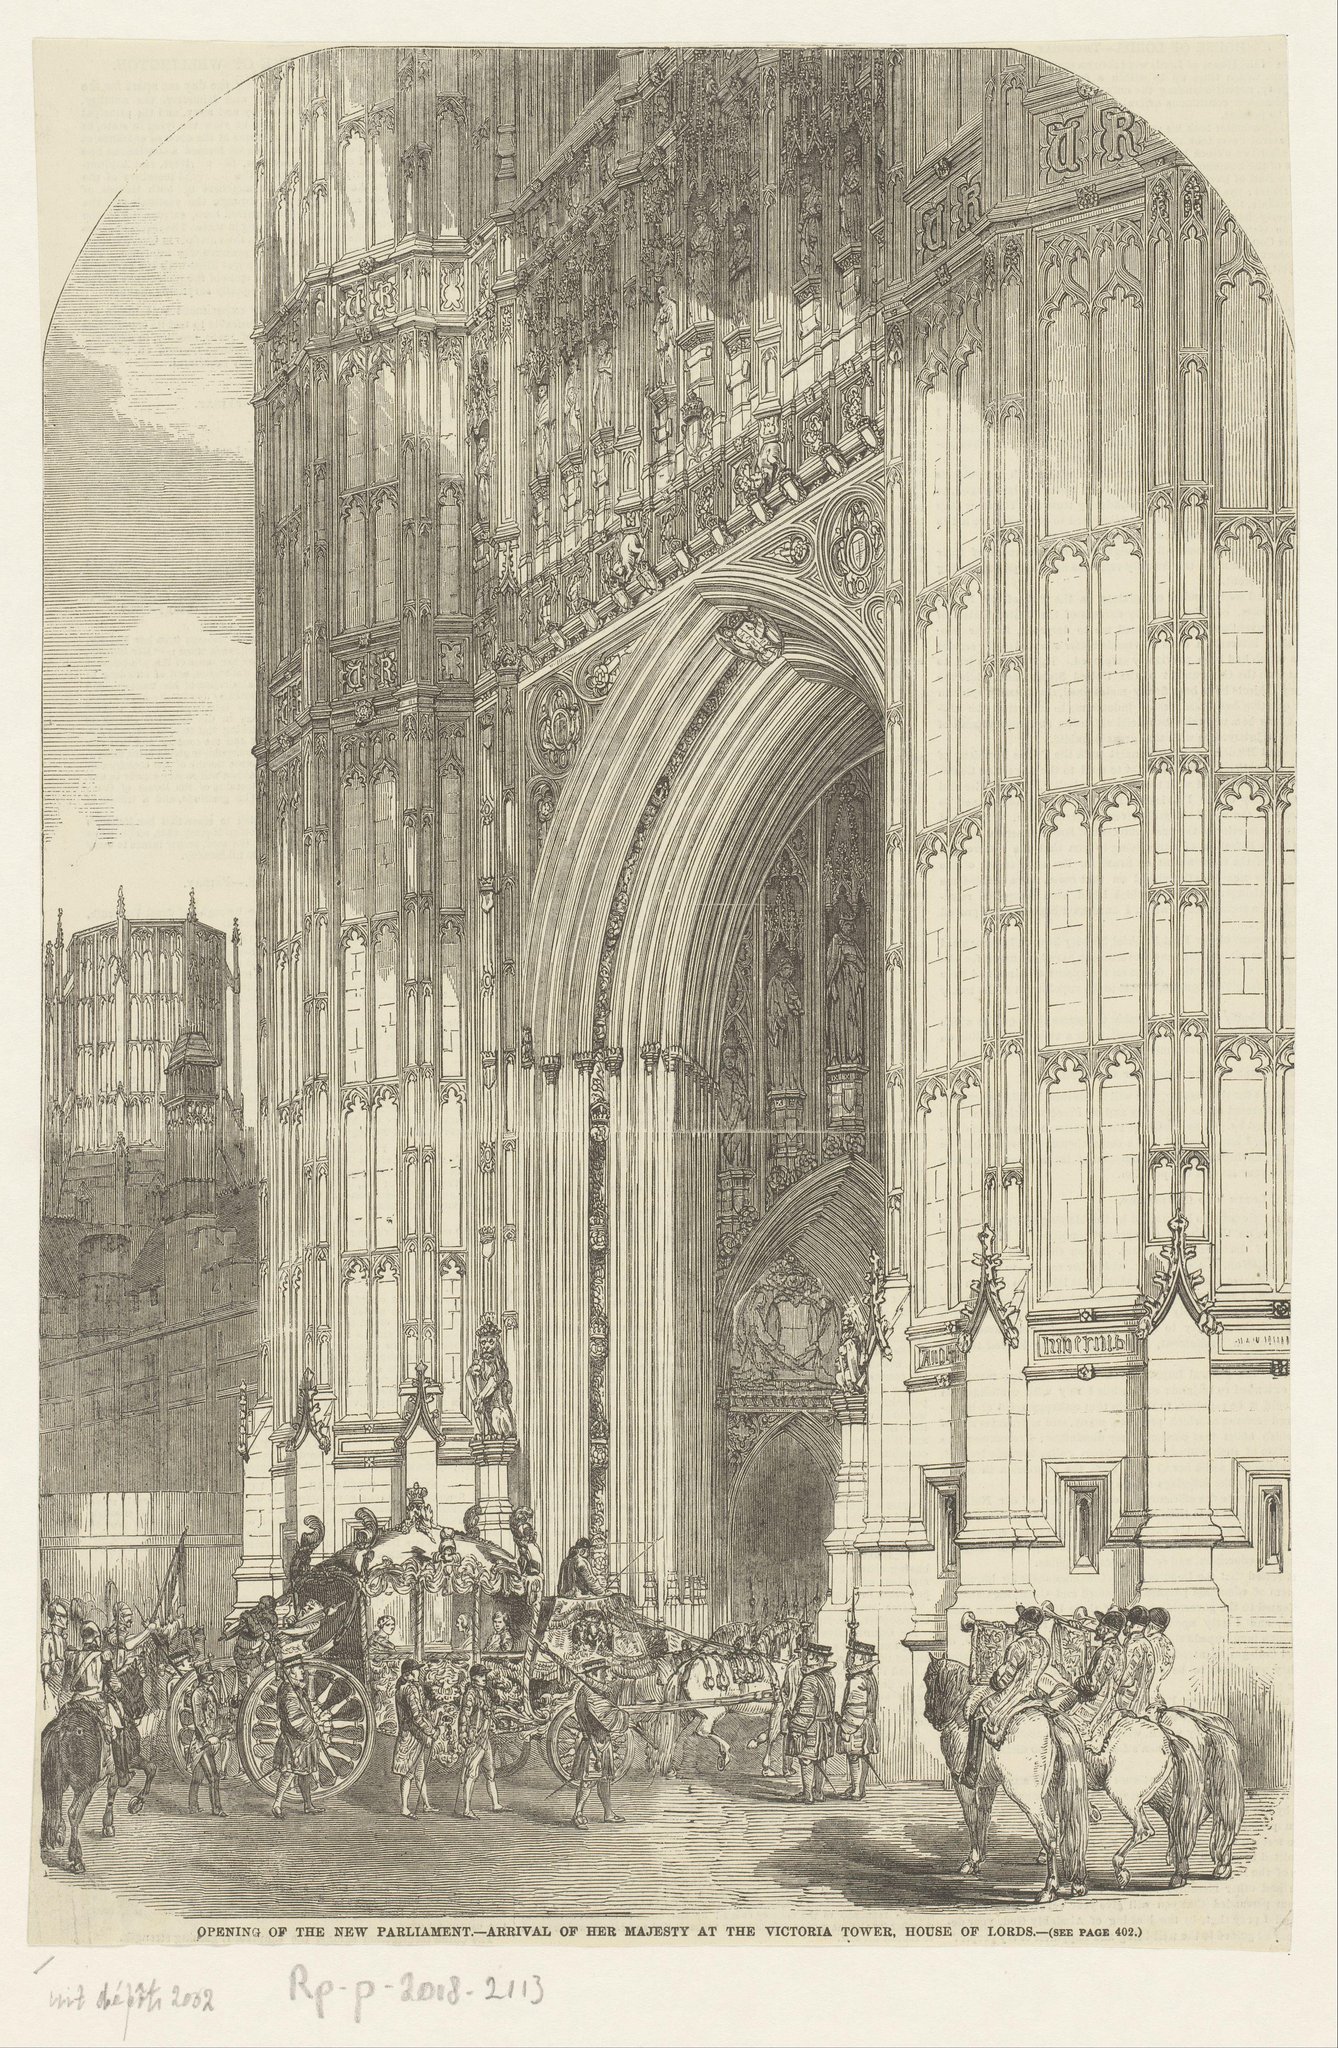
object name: print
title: The great octagon, or central hall, new Houses of Parliament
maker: Anonymous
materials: paper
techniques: letterpress printing, engraving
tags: tower (of house or building), lower house, parliament, chamber